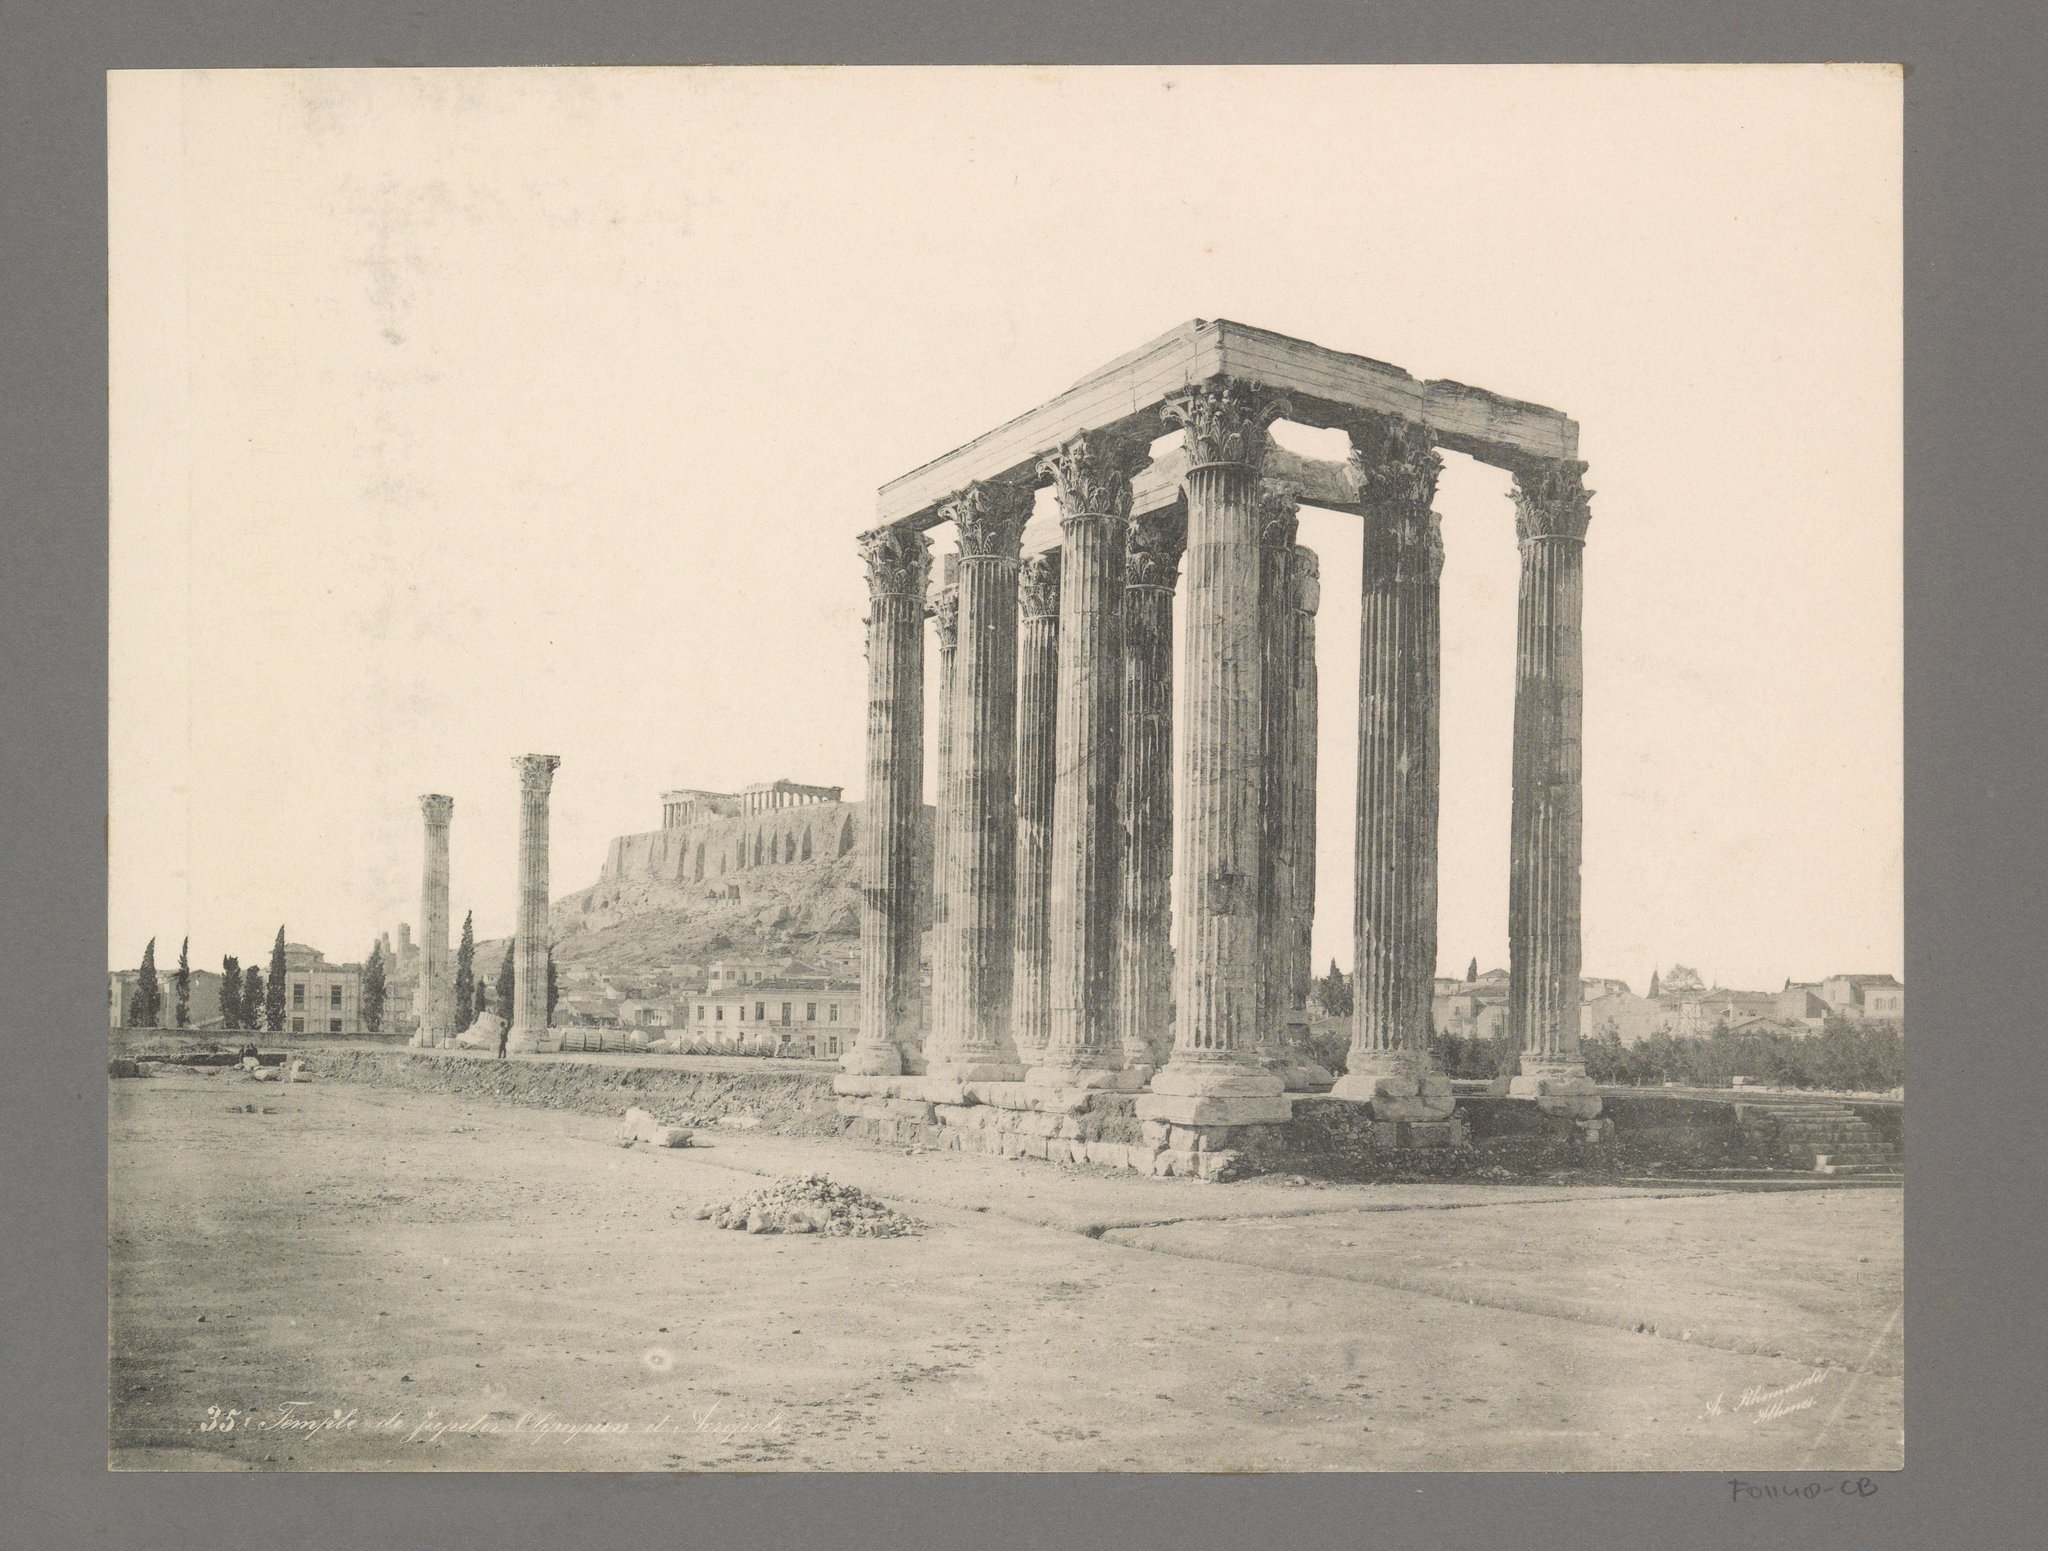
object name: album leaf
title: Gezicht op de Tempel van de Olympische Zeus in Athene met op de achtergrond de Akropolis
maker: aristotelis rhomaides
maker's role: fotograaf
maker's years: -1916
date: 1895-1905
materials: paper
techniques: photograph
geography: athens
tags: temple, shrine ~ greek religion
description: Onderdeel van Reisalbum met foto's van bezienswaardigheden in Griekenland en Egypte.